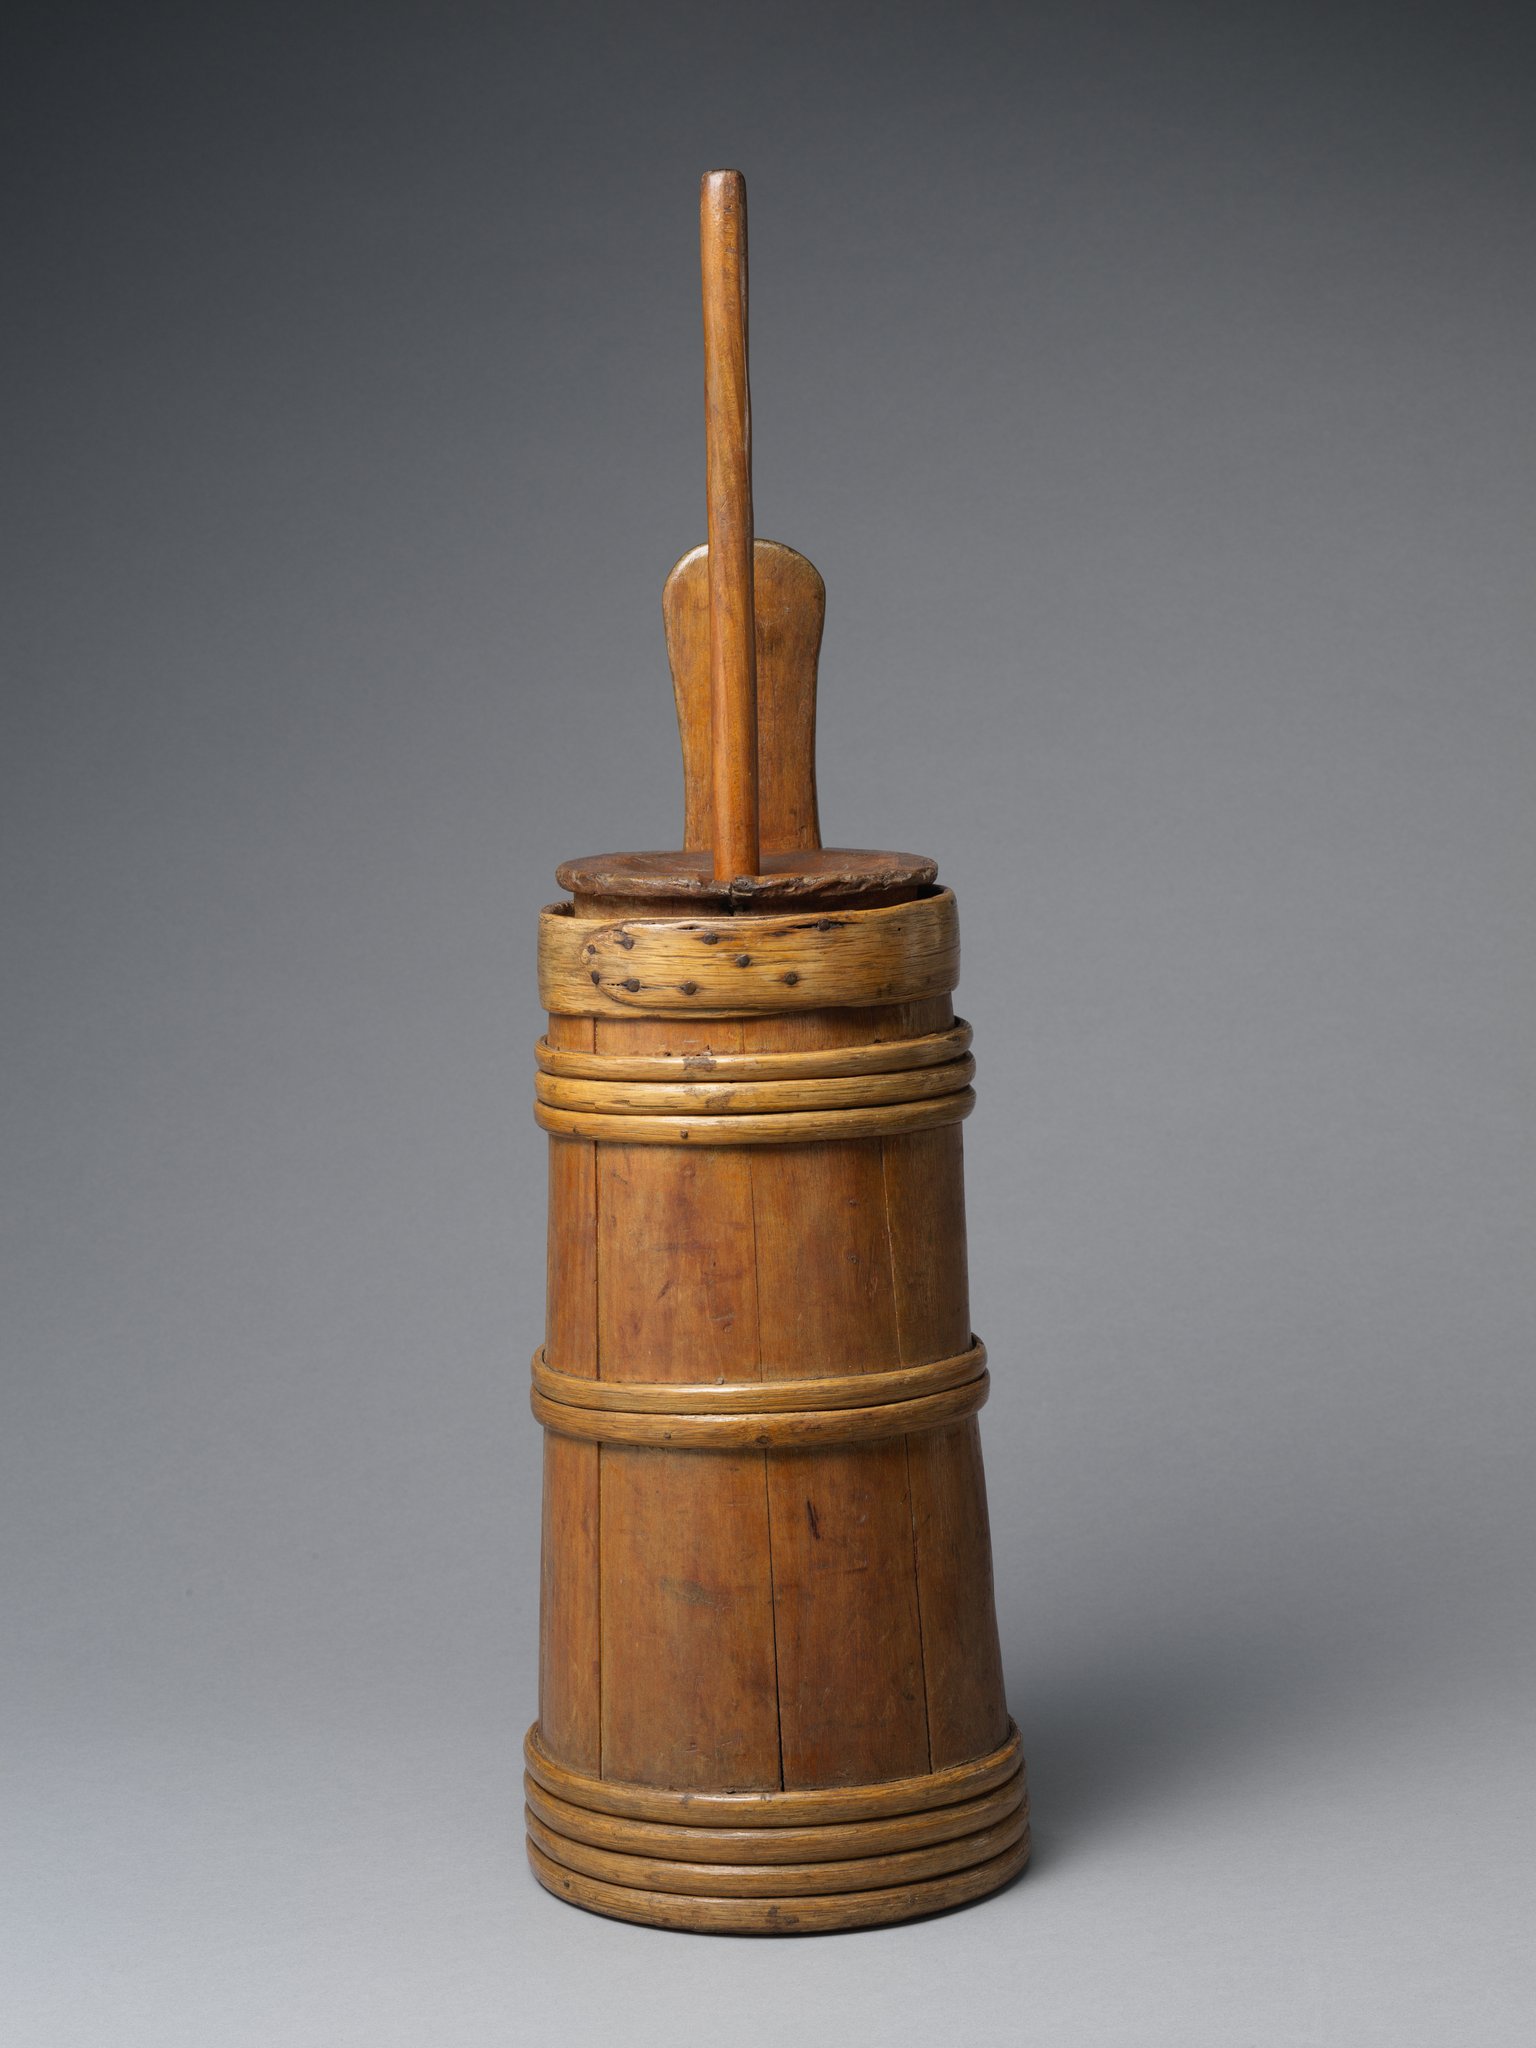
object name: churn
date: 1700-1800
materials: wood